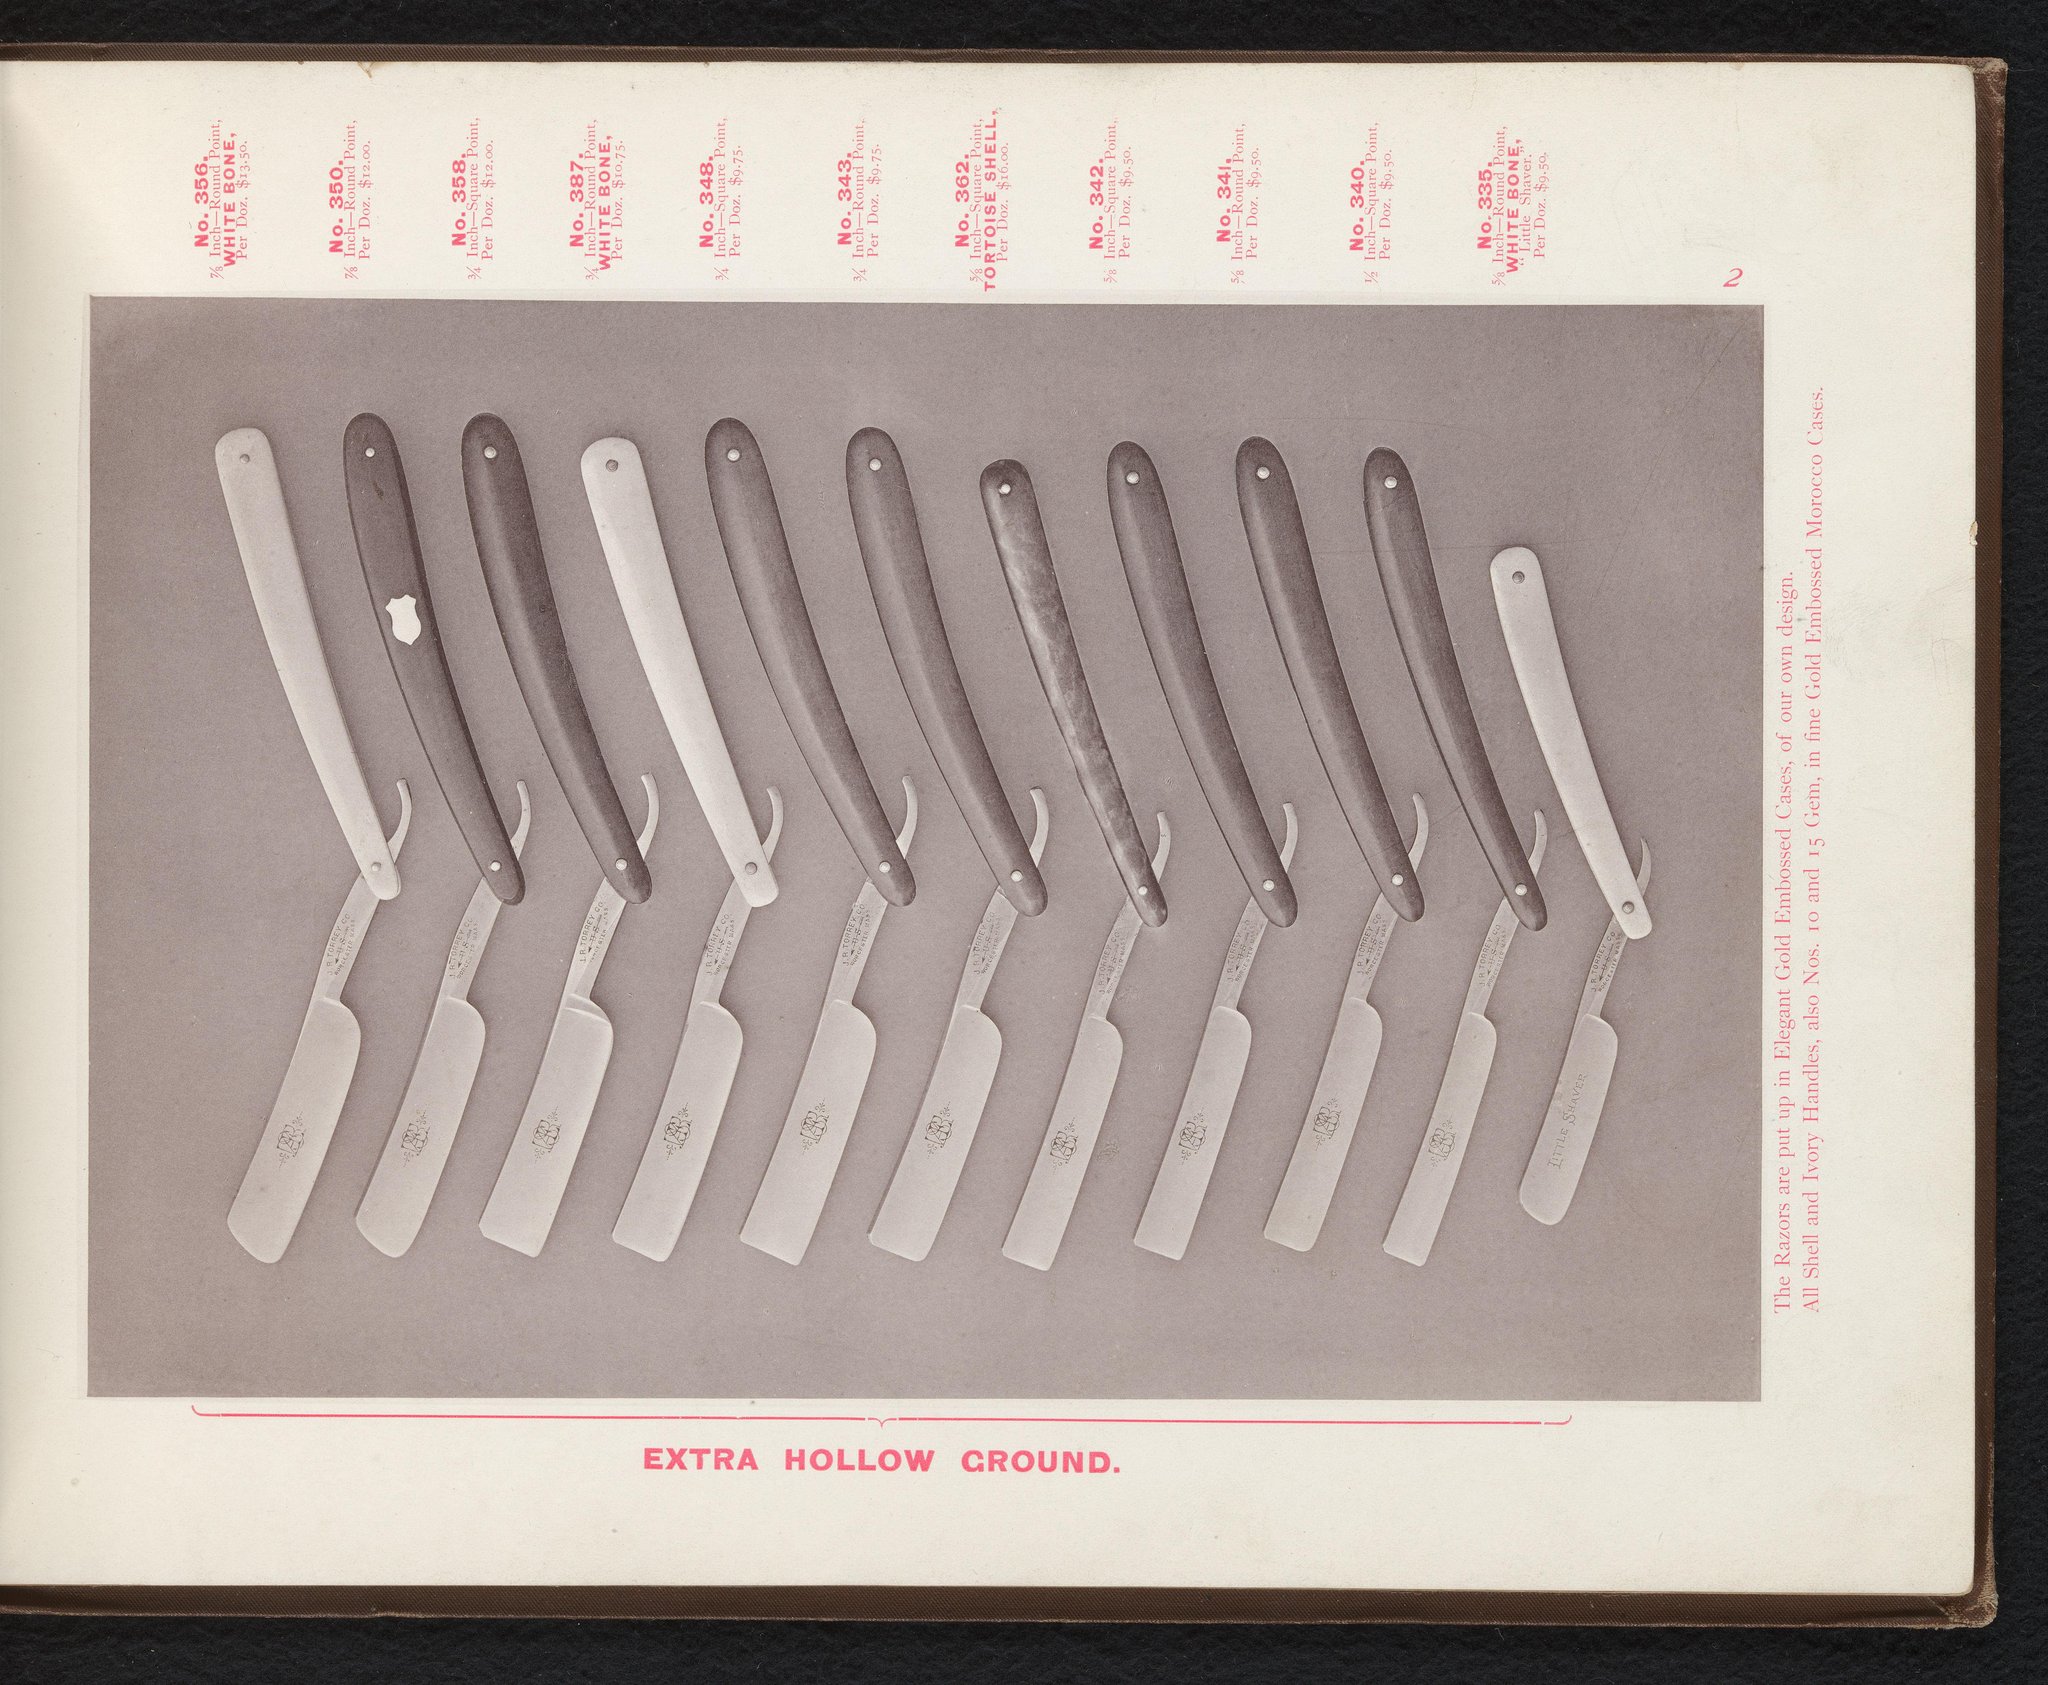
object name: photomechanical print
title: Extra hollow ground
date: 1876-1881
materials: paper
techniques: photograph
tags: razor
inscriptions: inscription: ‘The Razors are put up in Elegant Cases, of our own design./ All Shell and Ivory Handles, also Nos. 10 and 15 Gem, in fine Gold Embossed Morocco Cases./ [...]’